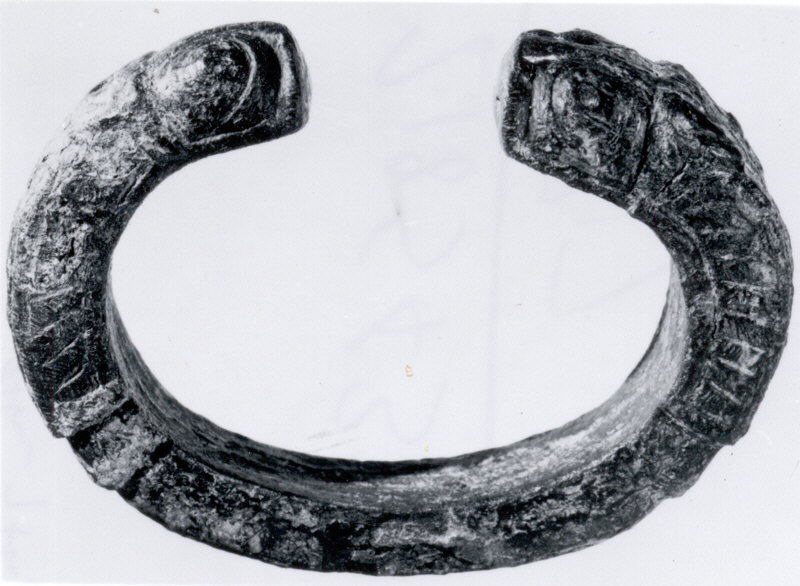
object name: bracelet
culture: iranian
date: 800-601 BCE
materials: iron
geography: iran, probably from luristan